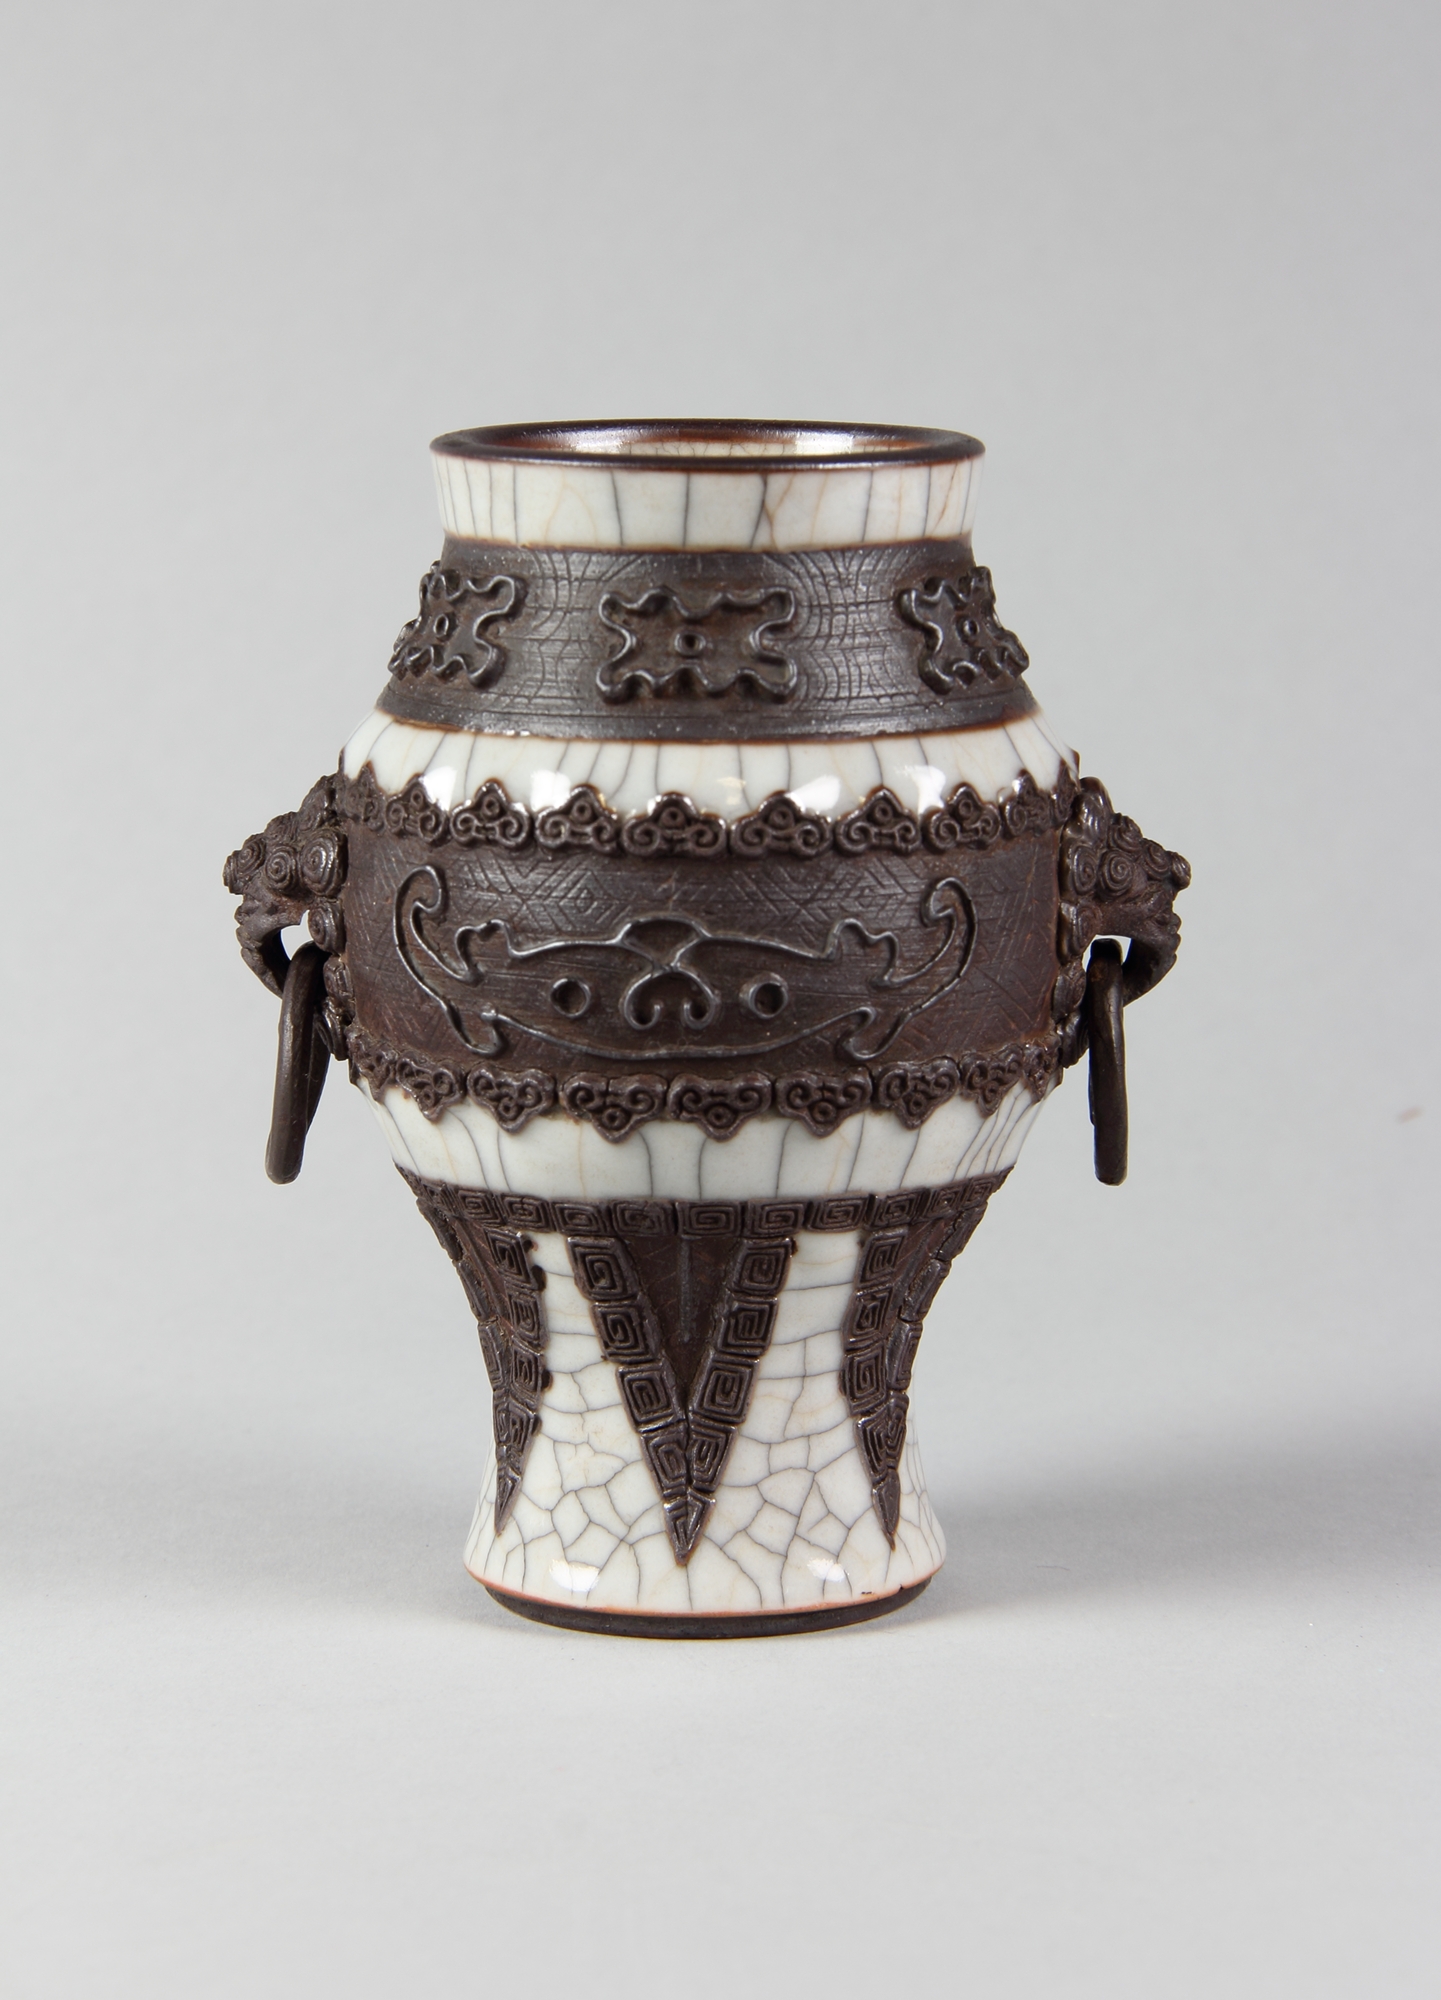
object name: vase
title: Vase with archaistic decoration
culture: chinese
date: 1801-1850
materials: biscuit, bronze, glaze, porcelain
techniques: relief